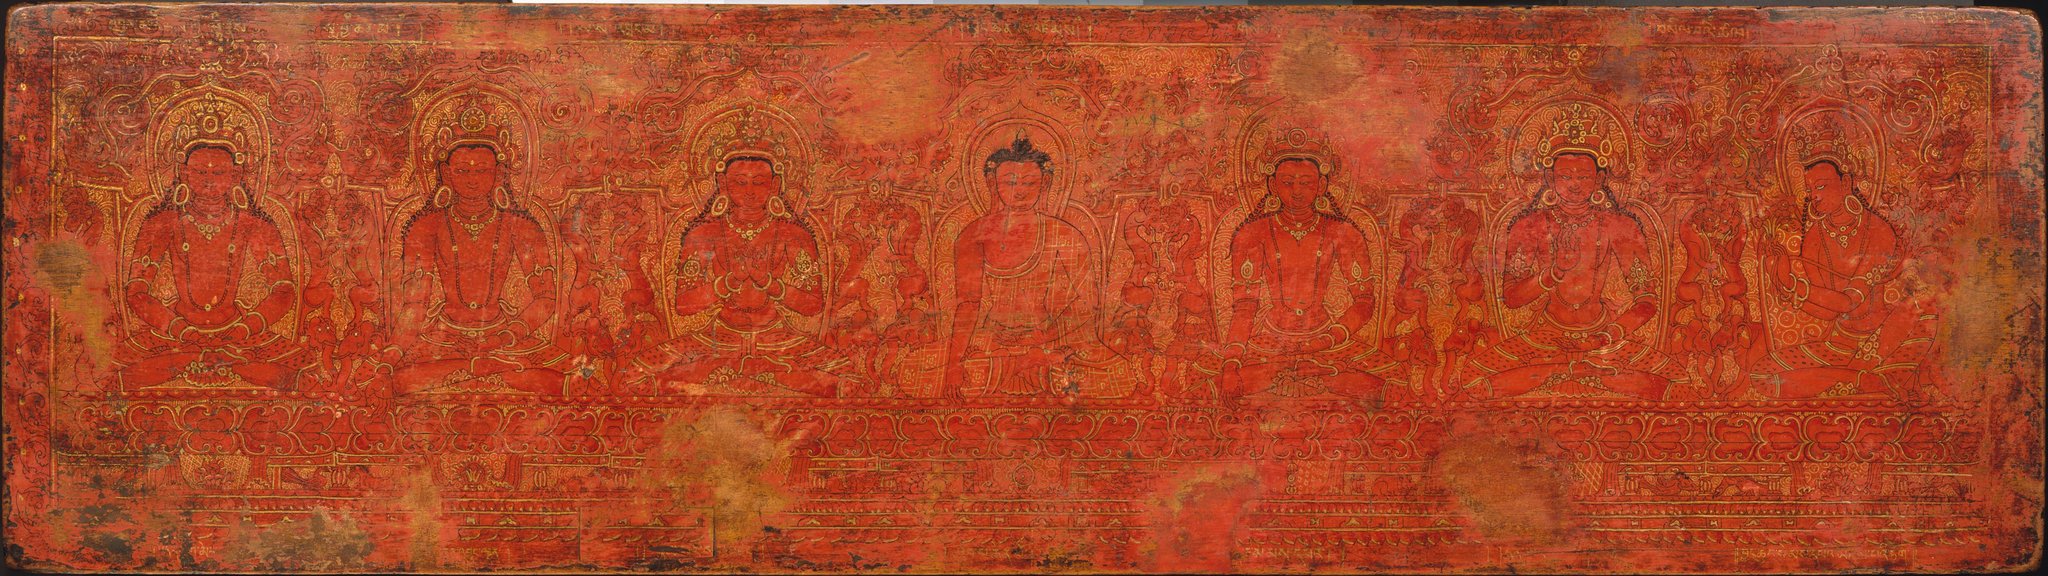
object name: manuscript cover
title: The Buddha Shakyamuni, Five Past Buddhas, and Maitreya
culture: tibetan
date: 1401-1500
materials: gold, ink, pigment, wood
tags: buddhism,buddha,maitreya,shakyamuni